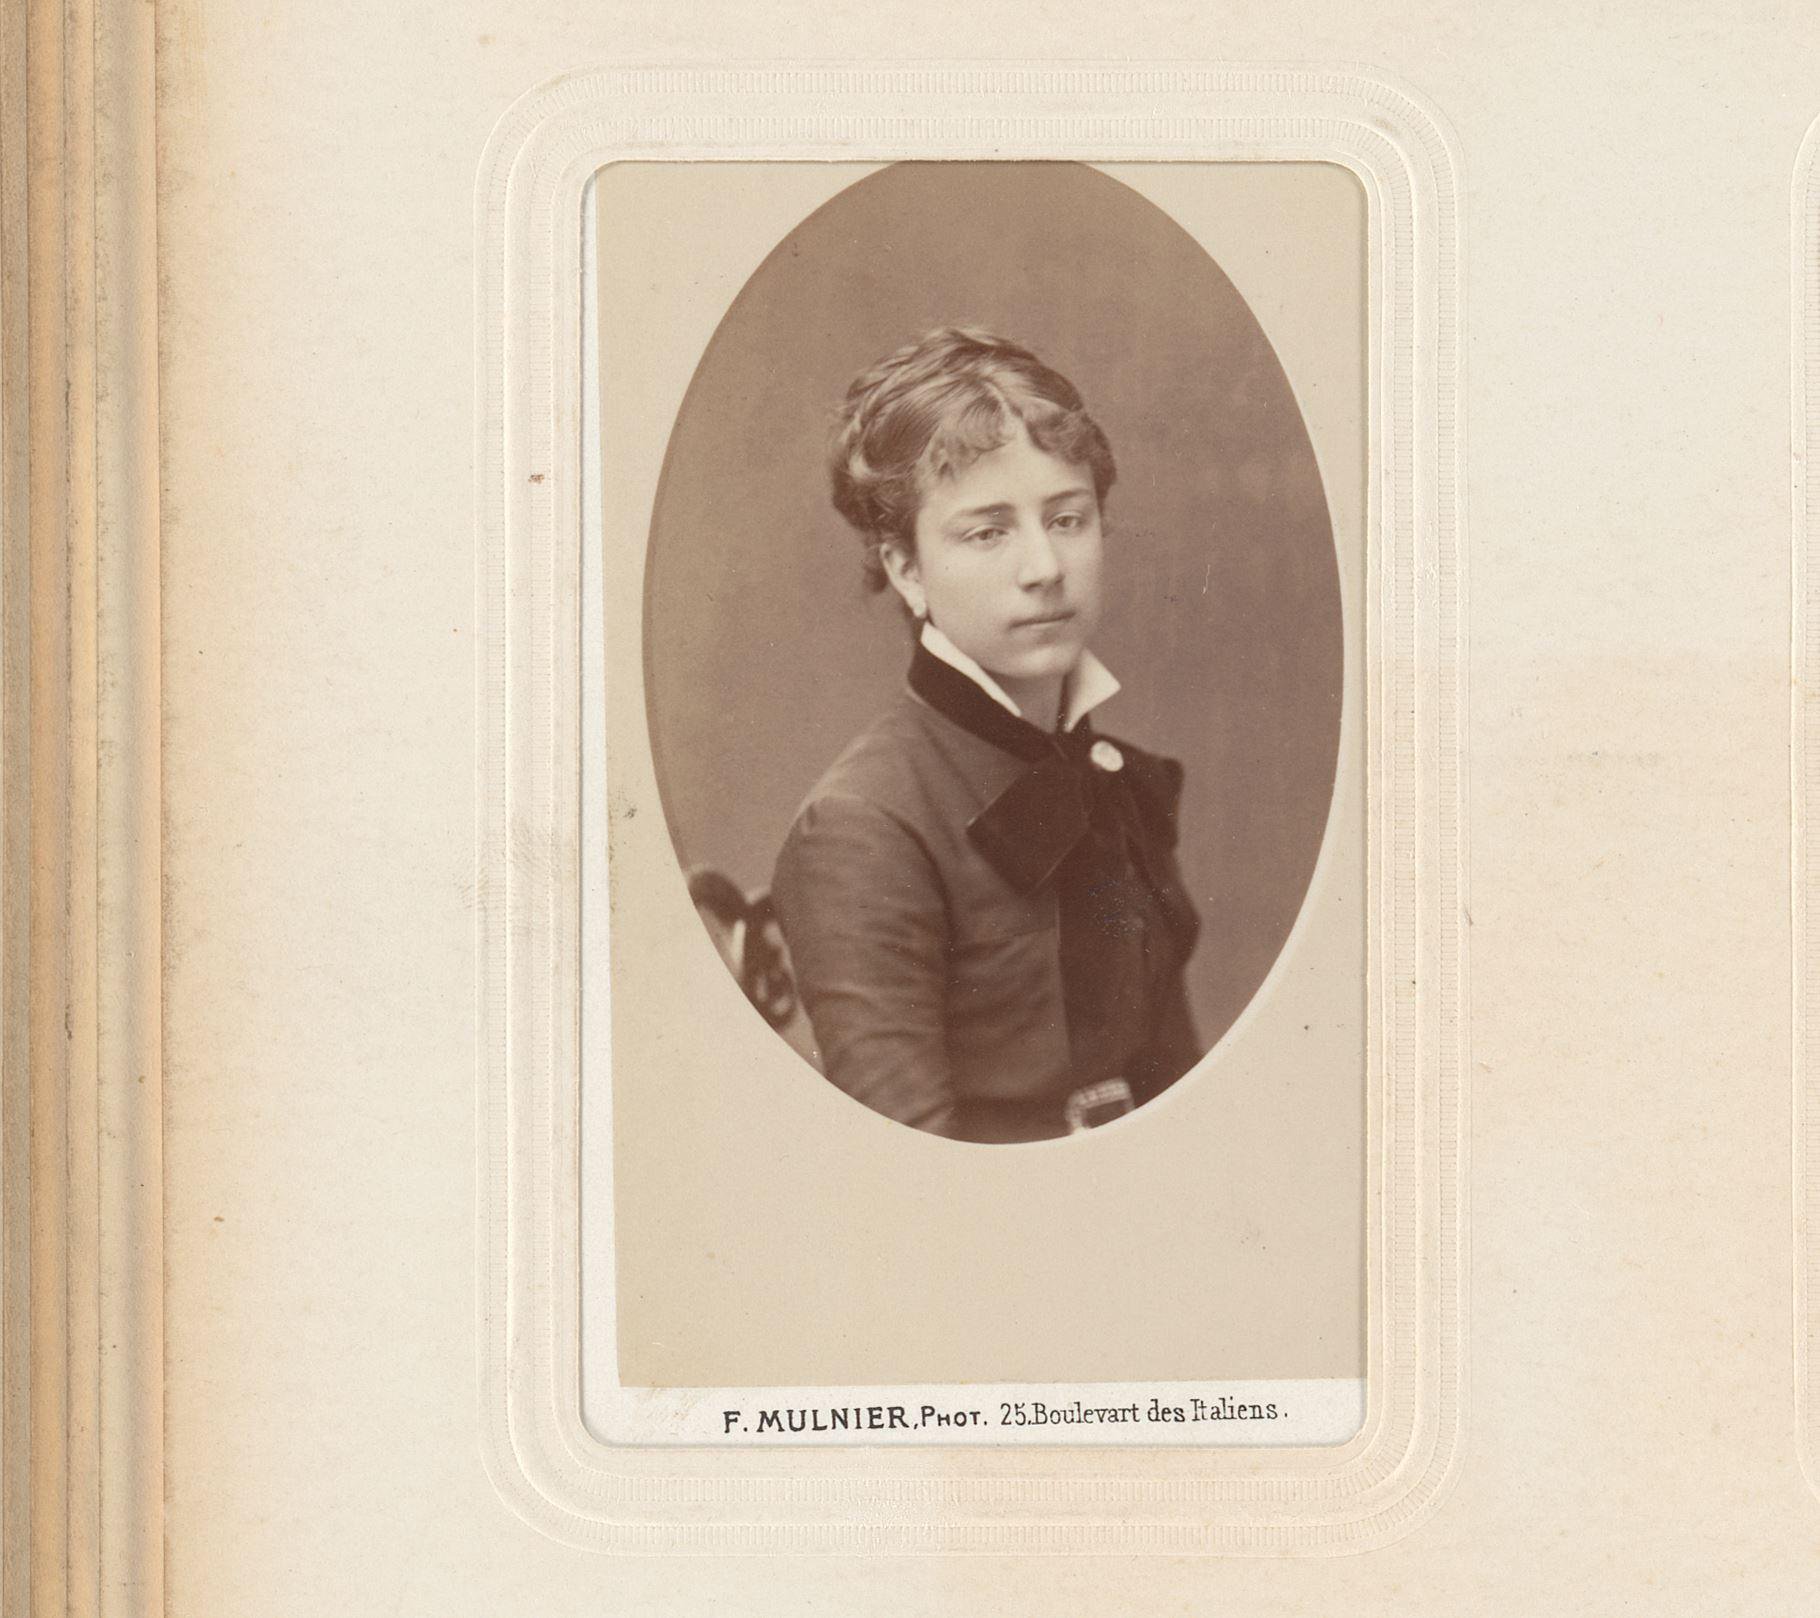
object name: photograph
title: Portret van een vrouw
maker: ferdinand mulnier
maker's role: painter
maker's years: 1817-1891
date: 1857-1879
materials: cardboard, paper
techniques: albumen print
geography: paris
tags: historical persons - bb - woman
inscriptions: address: ‘25, Boulevart des Italiens.’